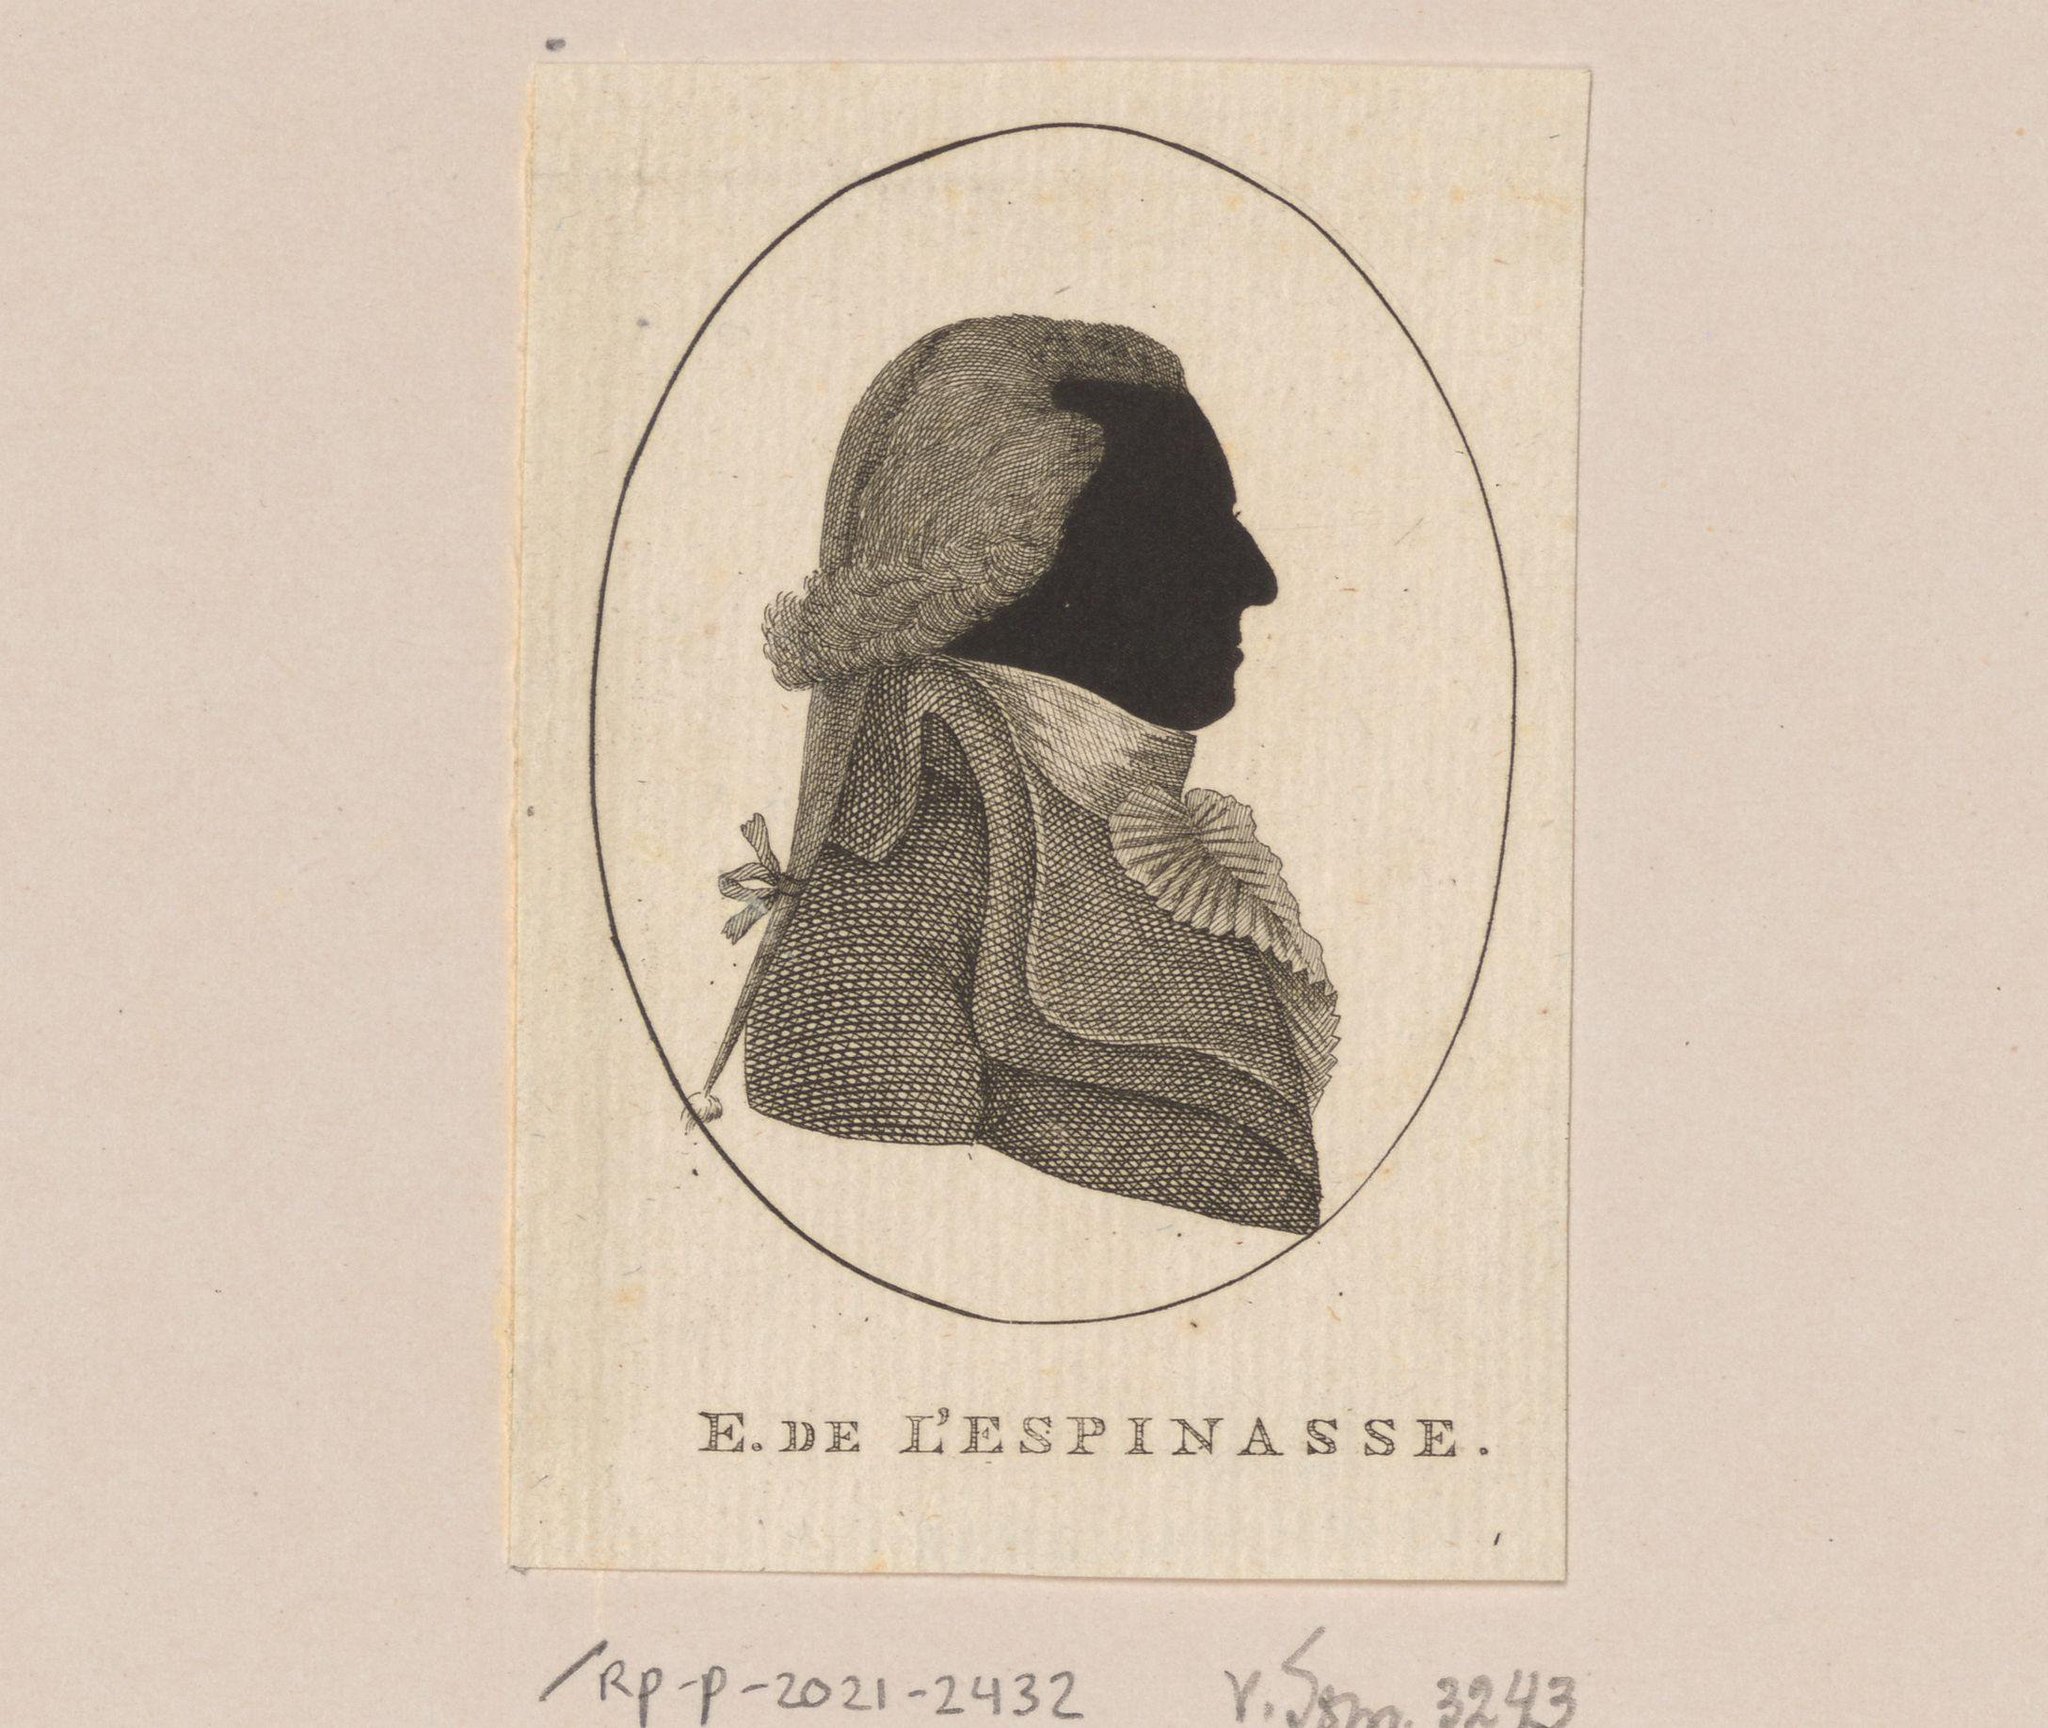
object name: print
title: Silhouetportret van Etienne Lespinasse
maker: Anonymous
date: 1799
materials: paper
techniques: etching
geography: netherlands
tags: amsterdam, historical persons, politician, e.g. party leader, wig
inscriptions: inscription: ‘R.b’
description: Prent waarschijnlijk uit: Rogge, Cornelius. Geschiedenis der staatsregeling, voor het Bataafsche volk. Amsterdam: Johannes Allart, 1799.